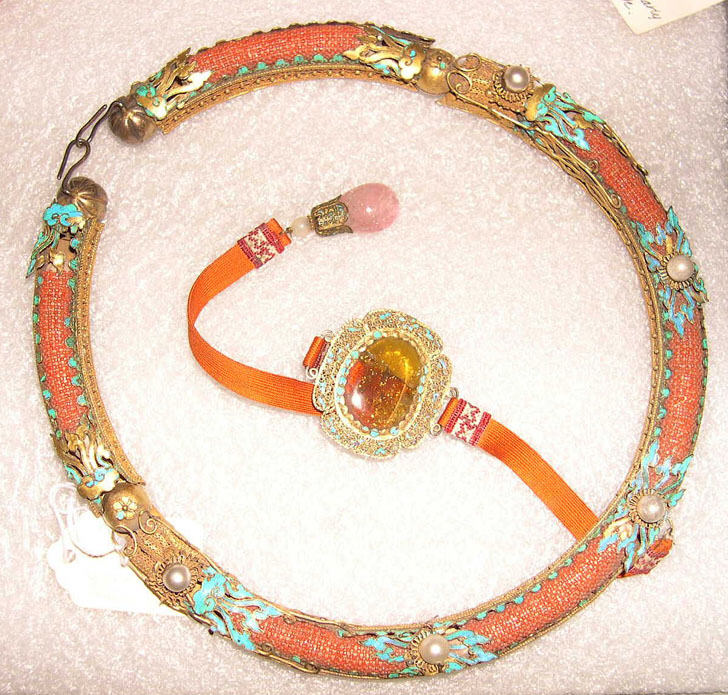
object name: necklace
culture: mongolian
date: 1801-1900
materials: feather, glass, metal, silk, stone